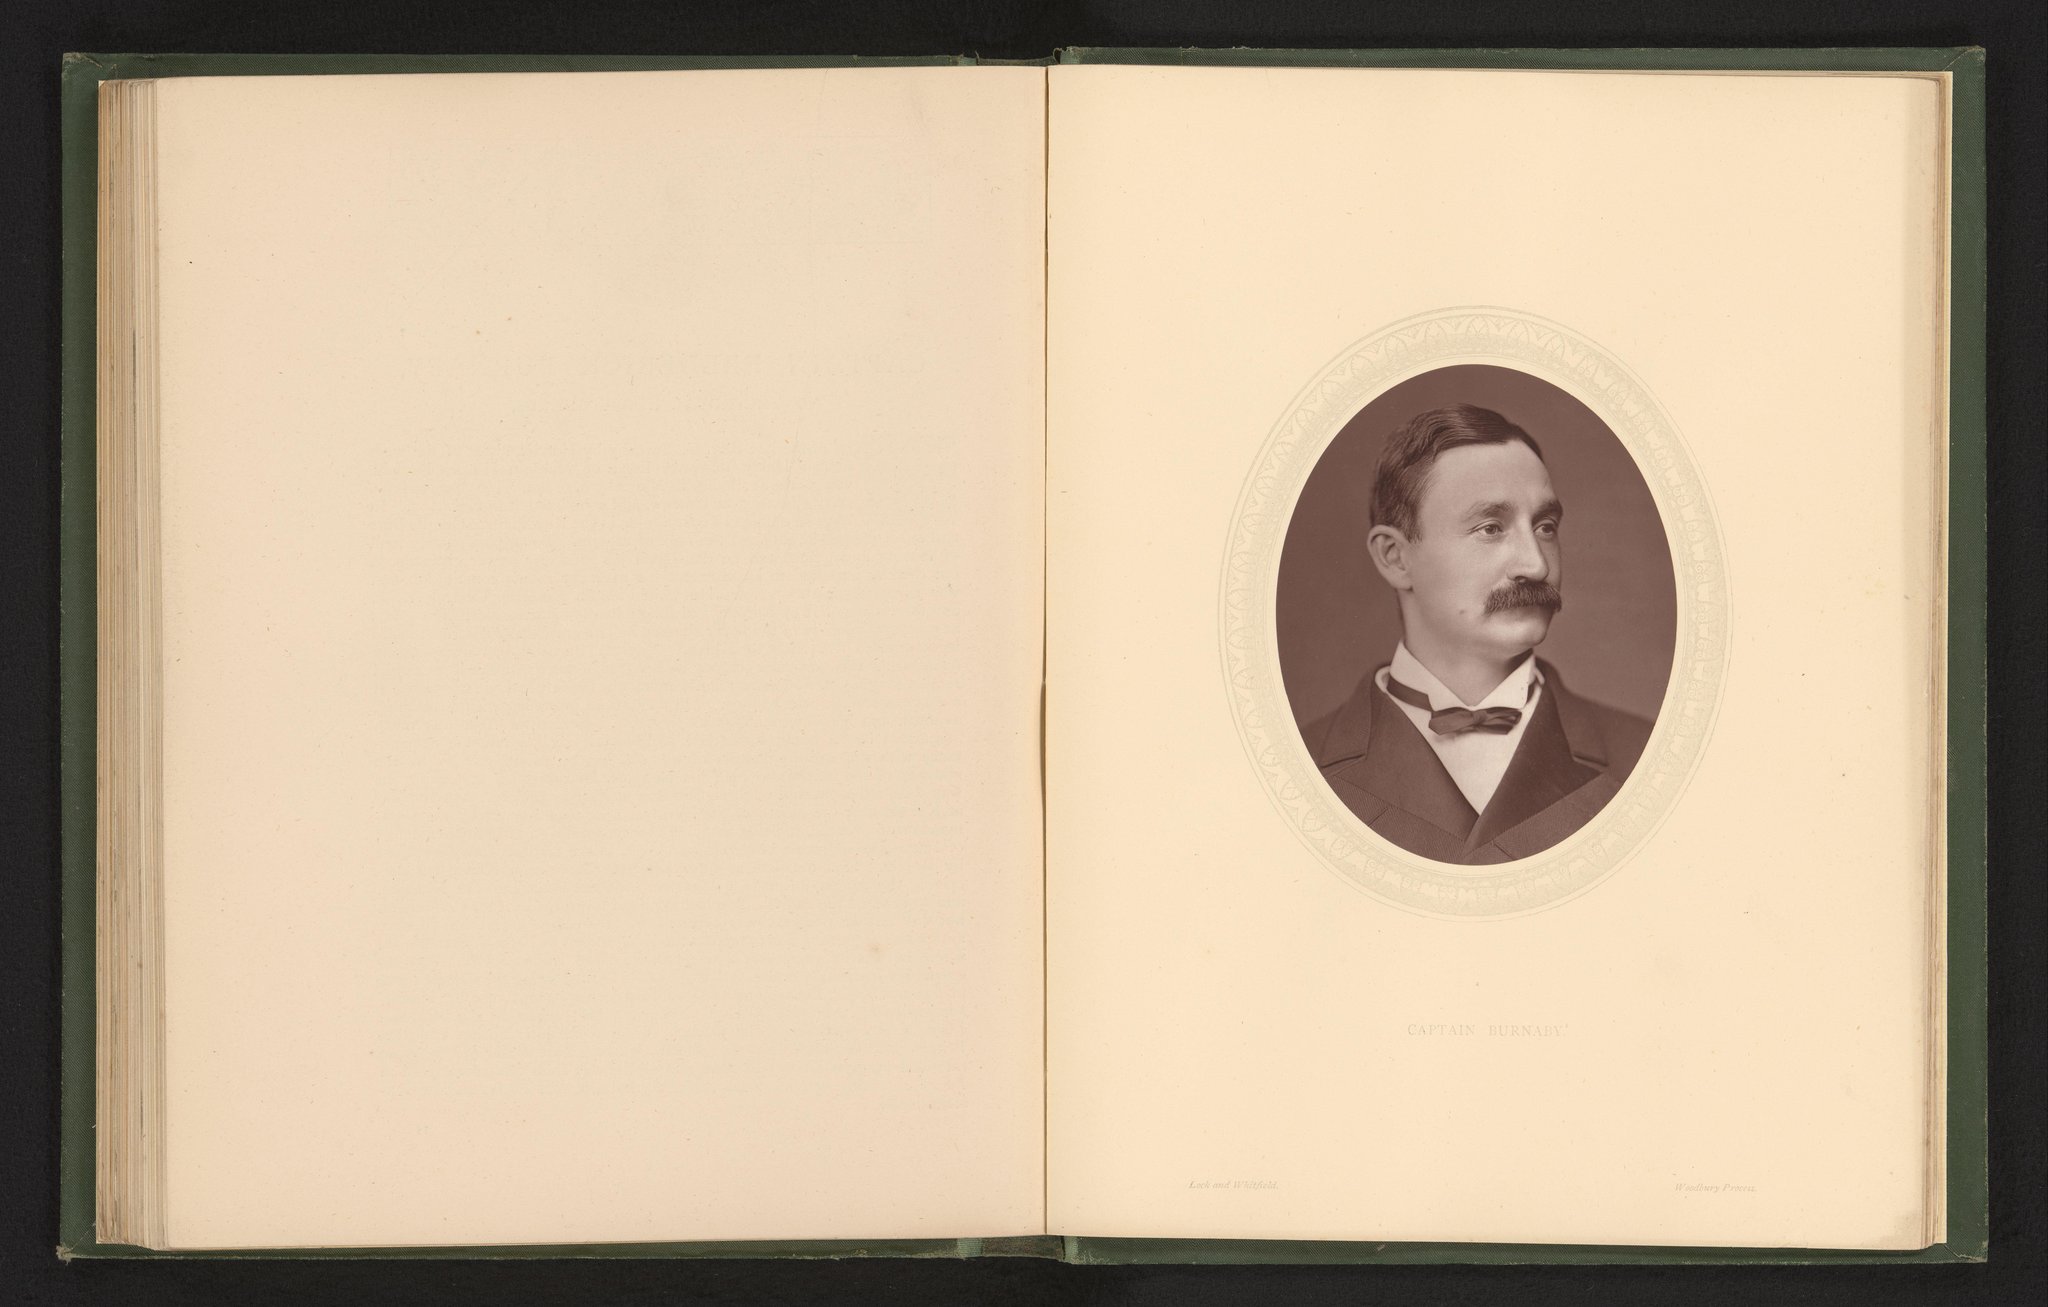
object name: page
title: Captain Burnaby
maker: Anonymous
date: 1872-1877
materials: paper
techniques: woodburytype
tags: historical persons (portraits and scenes from the life) (+ (full) bust portrait), officer